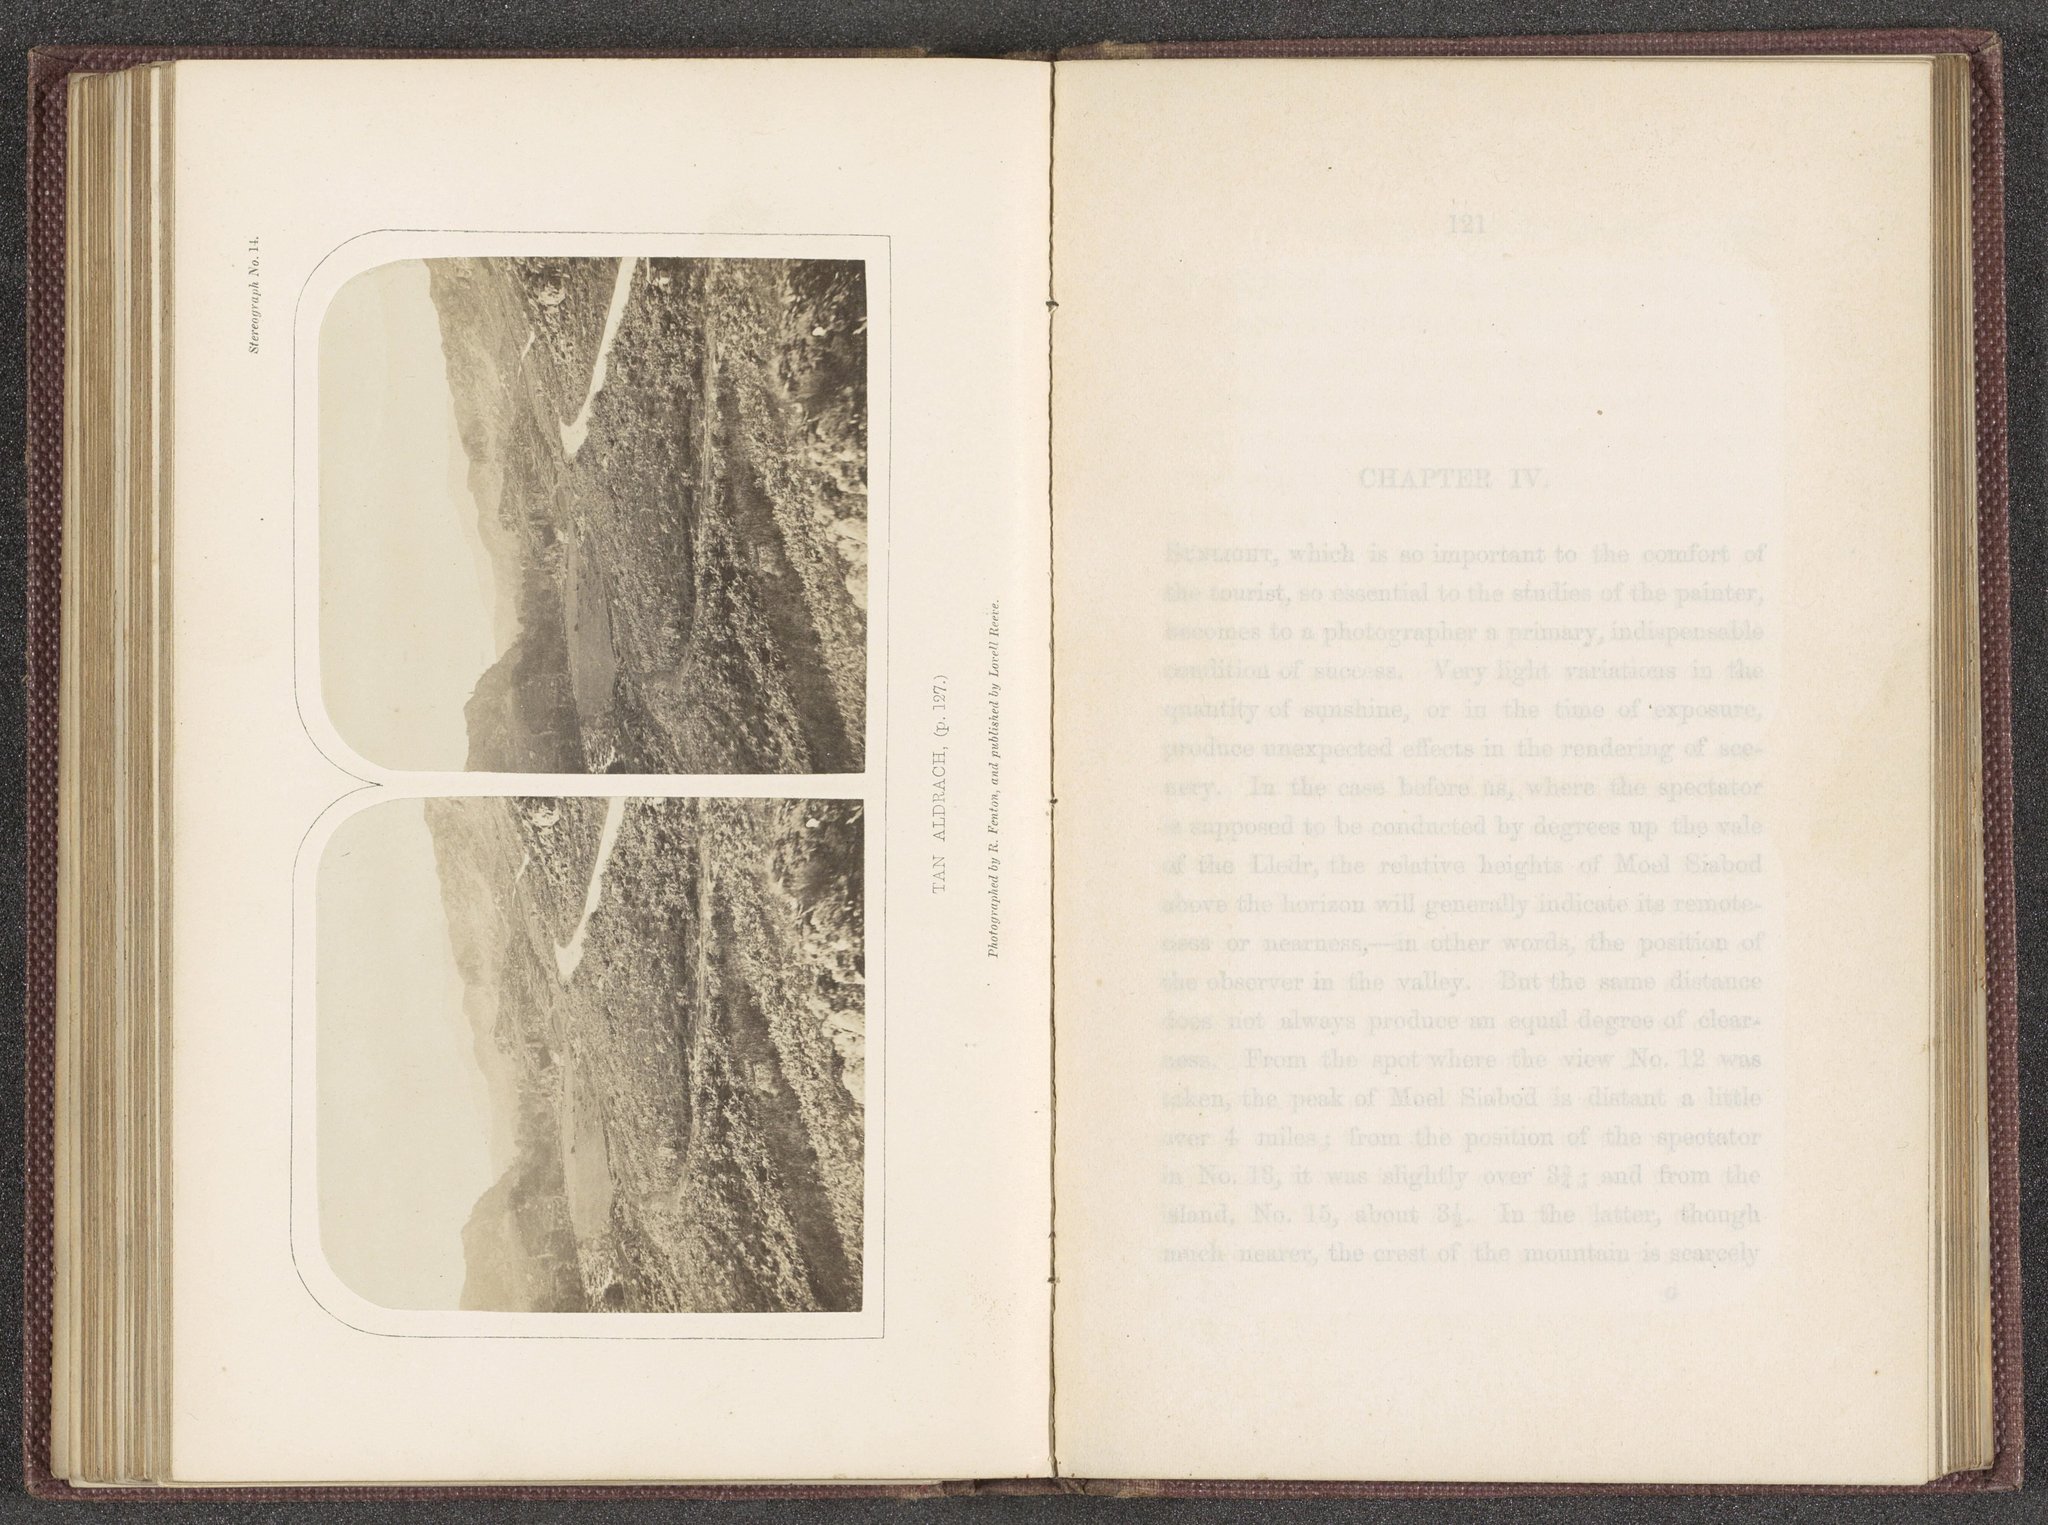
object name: page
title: Tan Aldrach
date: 1859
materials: paper, photographic support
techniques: albumen print, printing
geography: wales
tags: dale, valley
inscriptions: number: ‘Stereograph No. 14.’